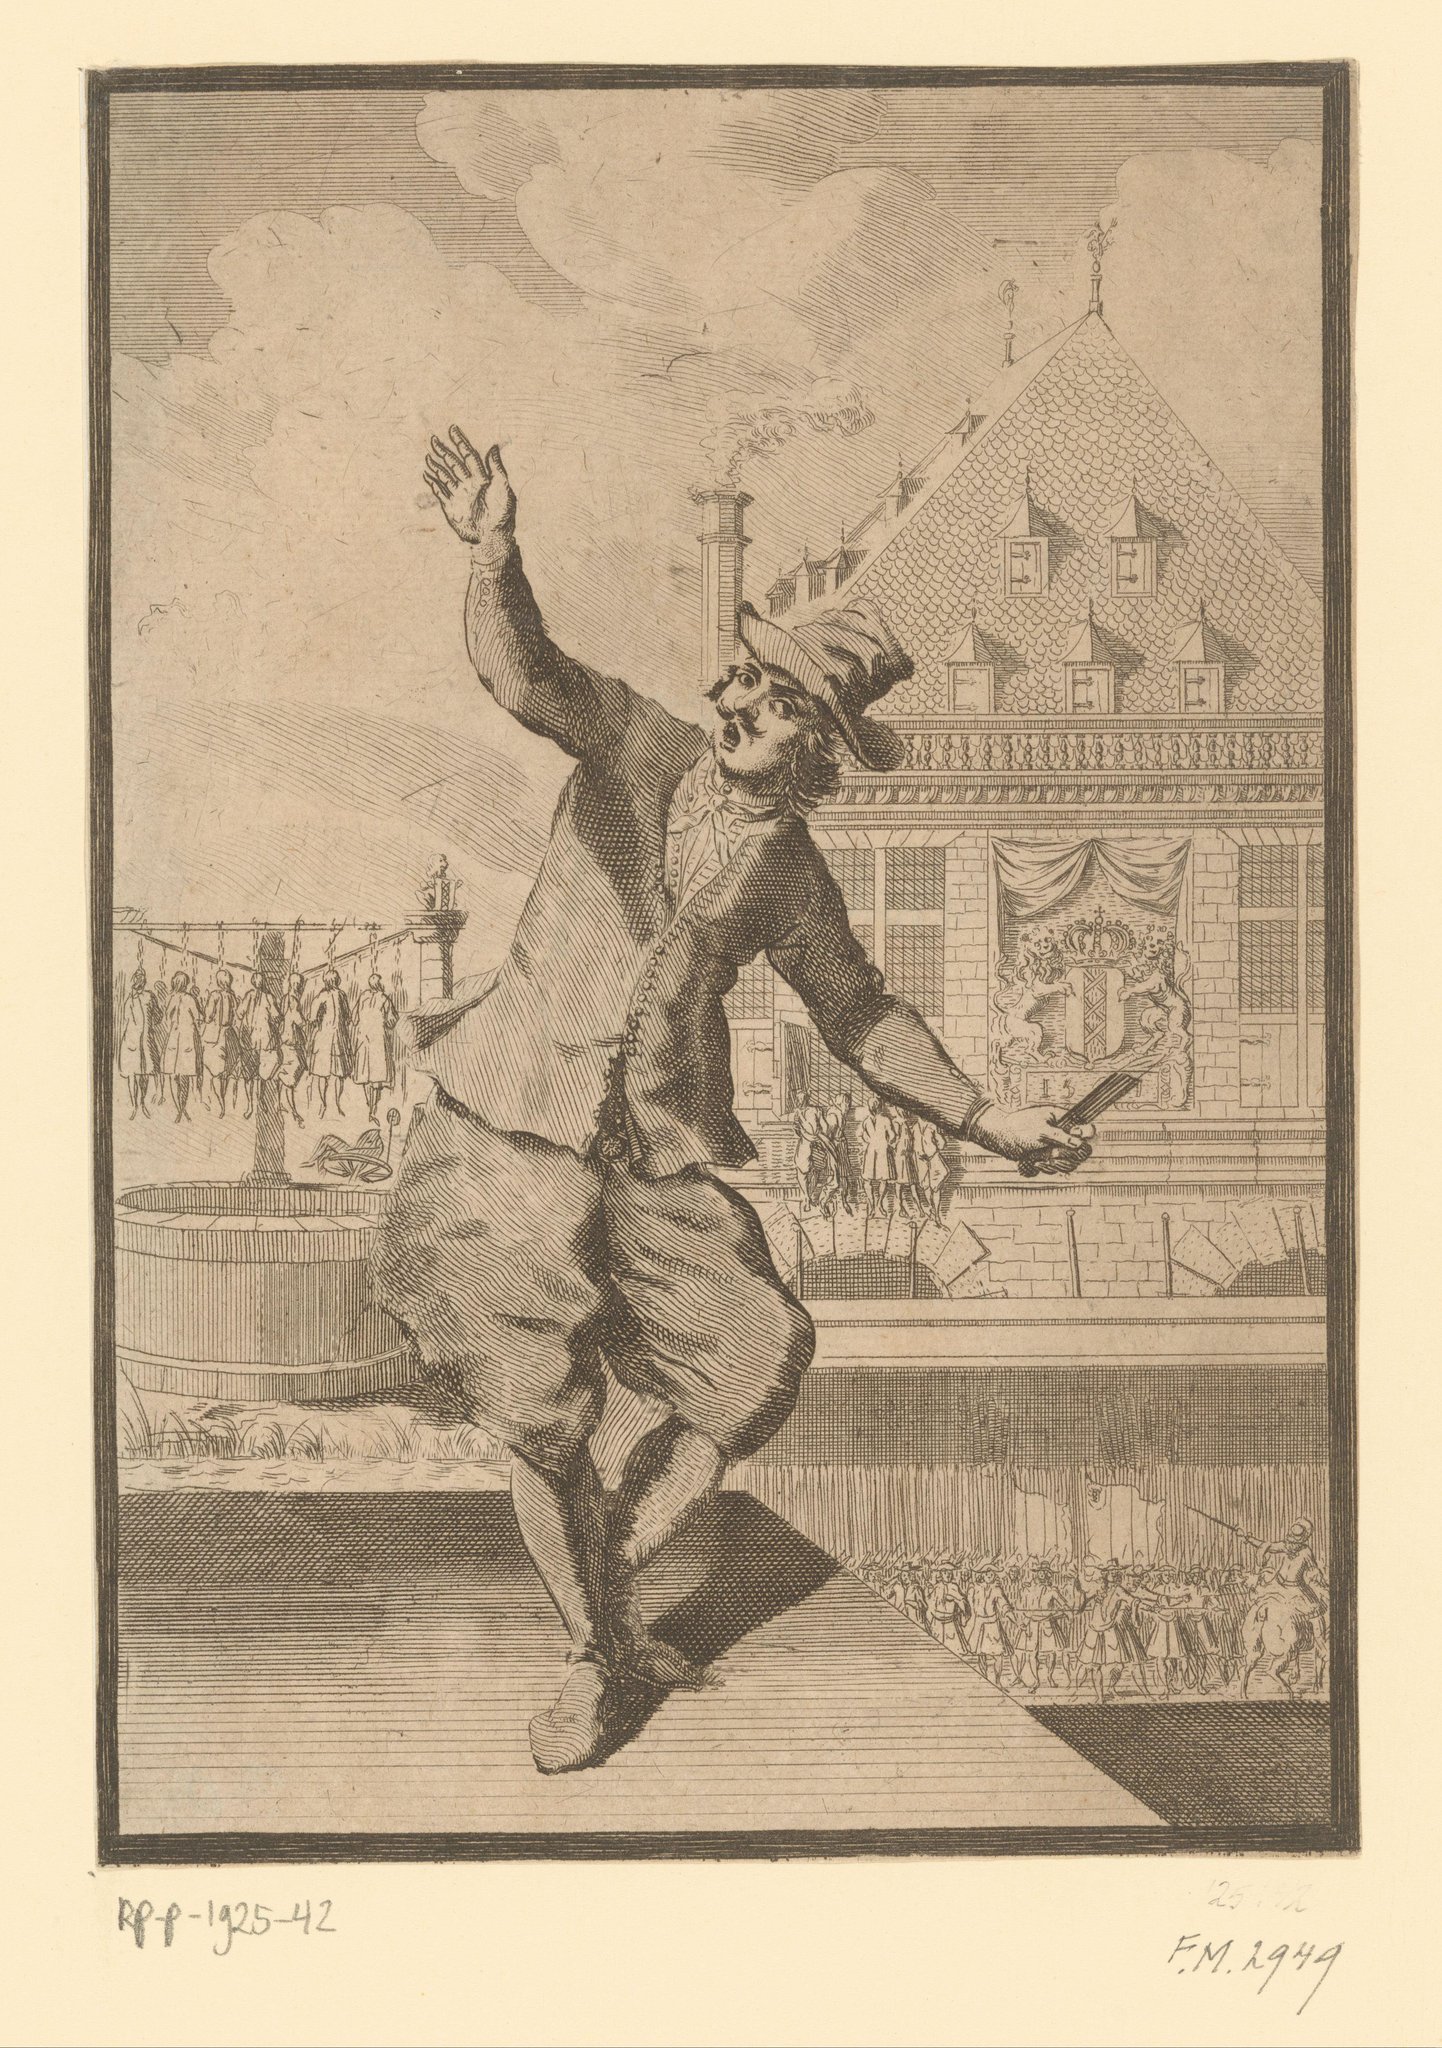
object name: print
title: Plunderaar uit het Aansprekersoproer te Amsterdam, 1696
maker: pieter van den berge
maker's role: draughtsman, print maker, printer, publisher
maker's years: 1659-1737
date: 1696-1698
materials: paper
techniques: engraving, etching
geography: amsterdam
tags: violent death by hanging, plundering ~ riot, weigh-house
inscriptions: collector's mark: Lugt 2233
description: Spotprent op een plunderaar uit het Aansprekersoproer te Amsterdam, 31 januari-1 februari 1696. De man staat met open mond en mes in de linkerhand op een stellage, op de achtergrond hangen de lijken van veroordeelde plunderaars aan de gevel van de Waag en op het galgenveld.